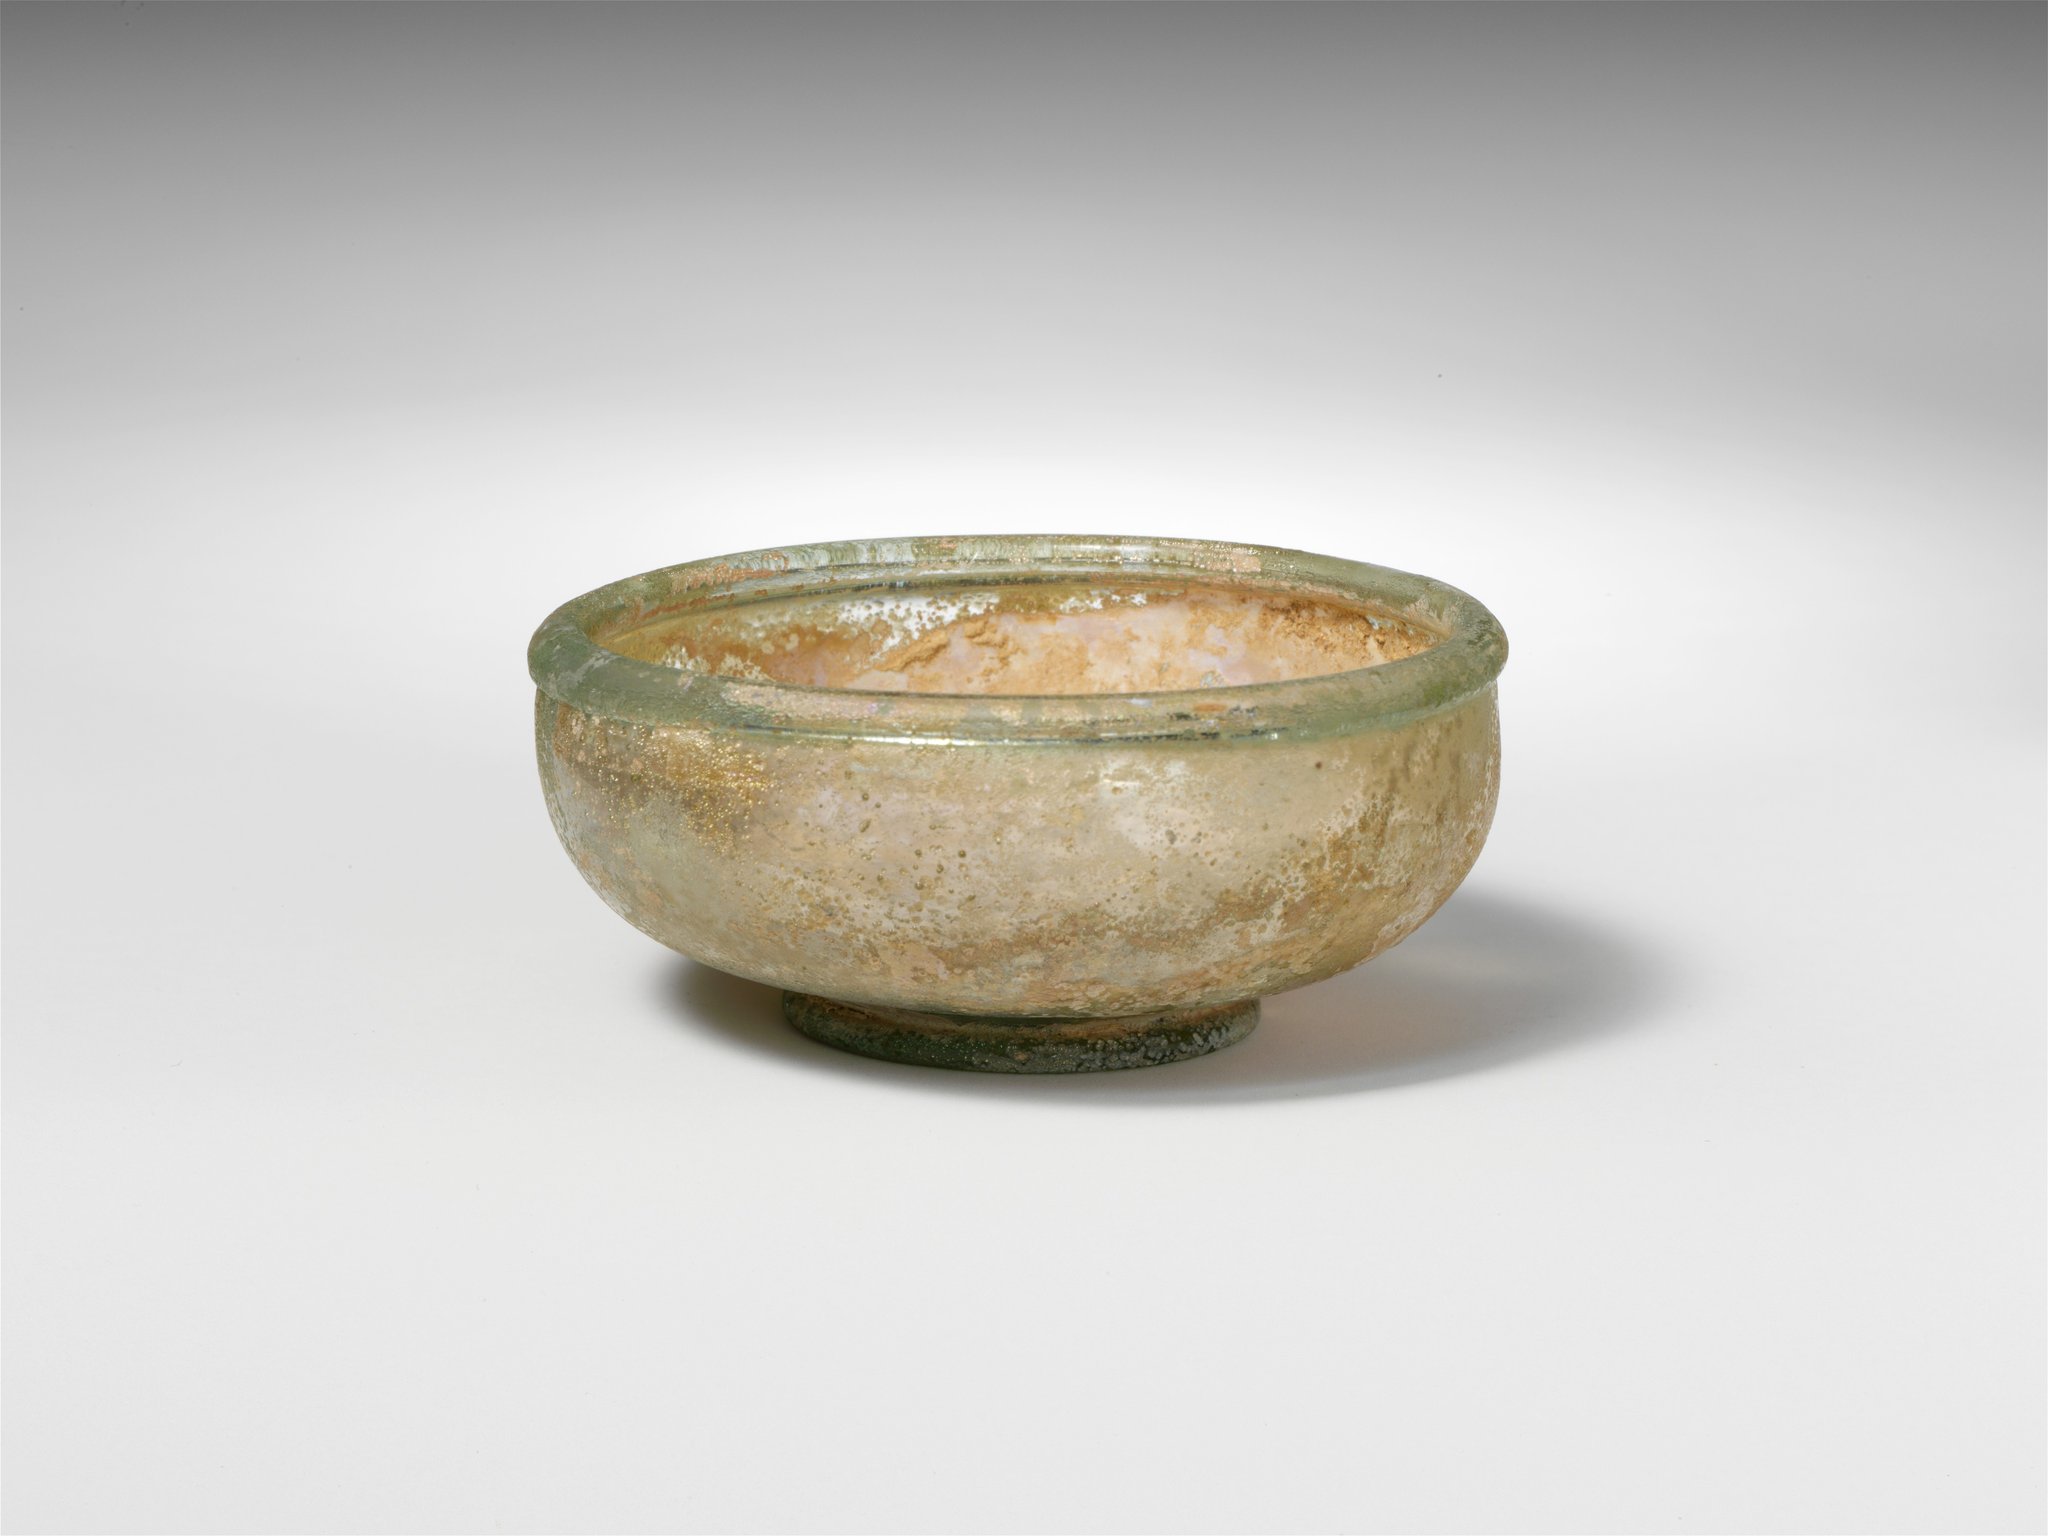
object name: bowl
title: Glass bowl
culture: roman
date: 201-300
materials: glass